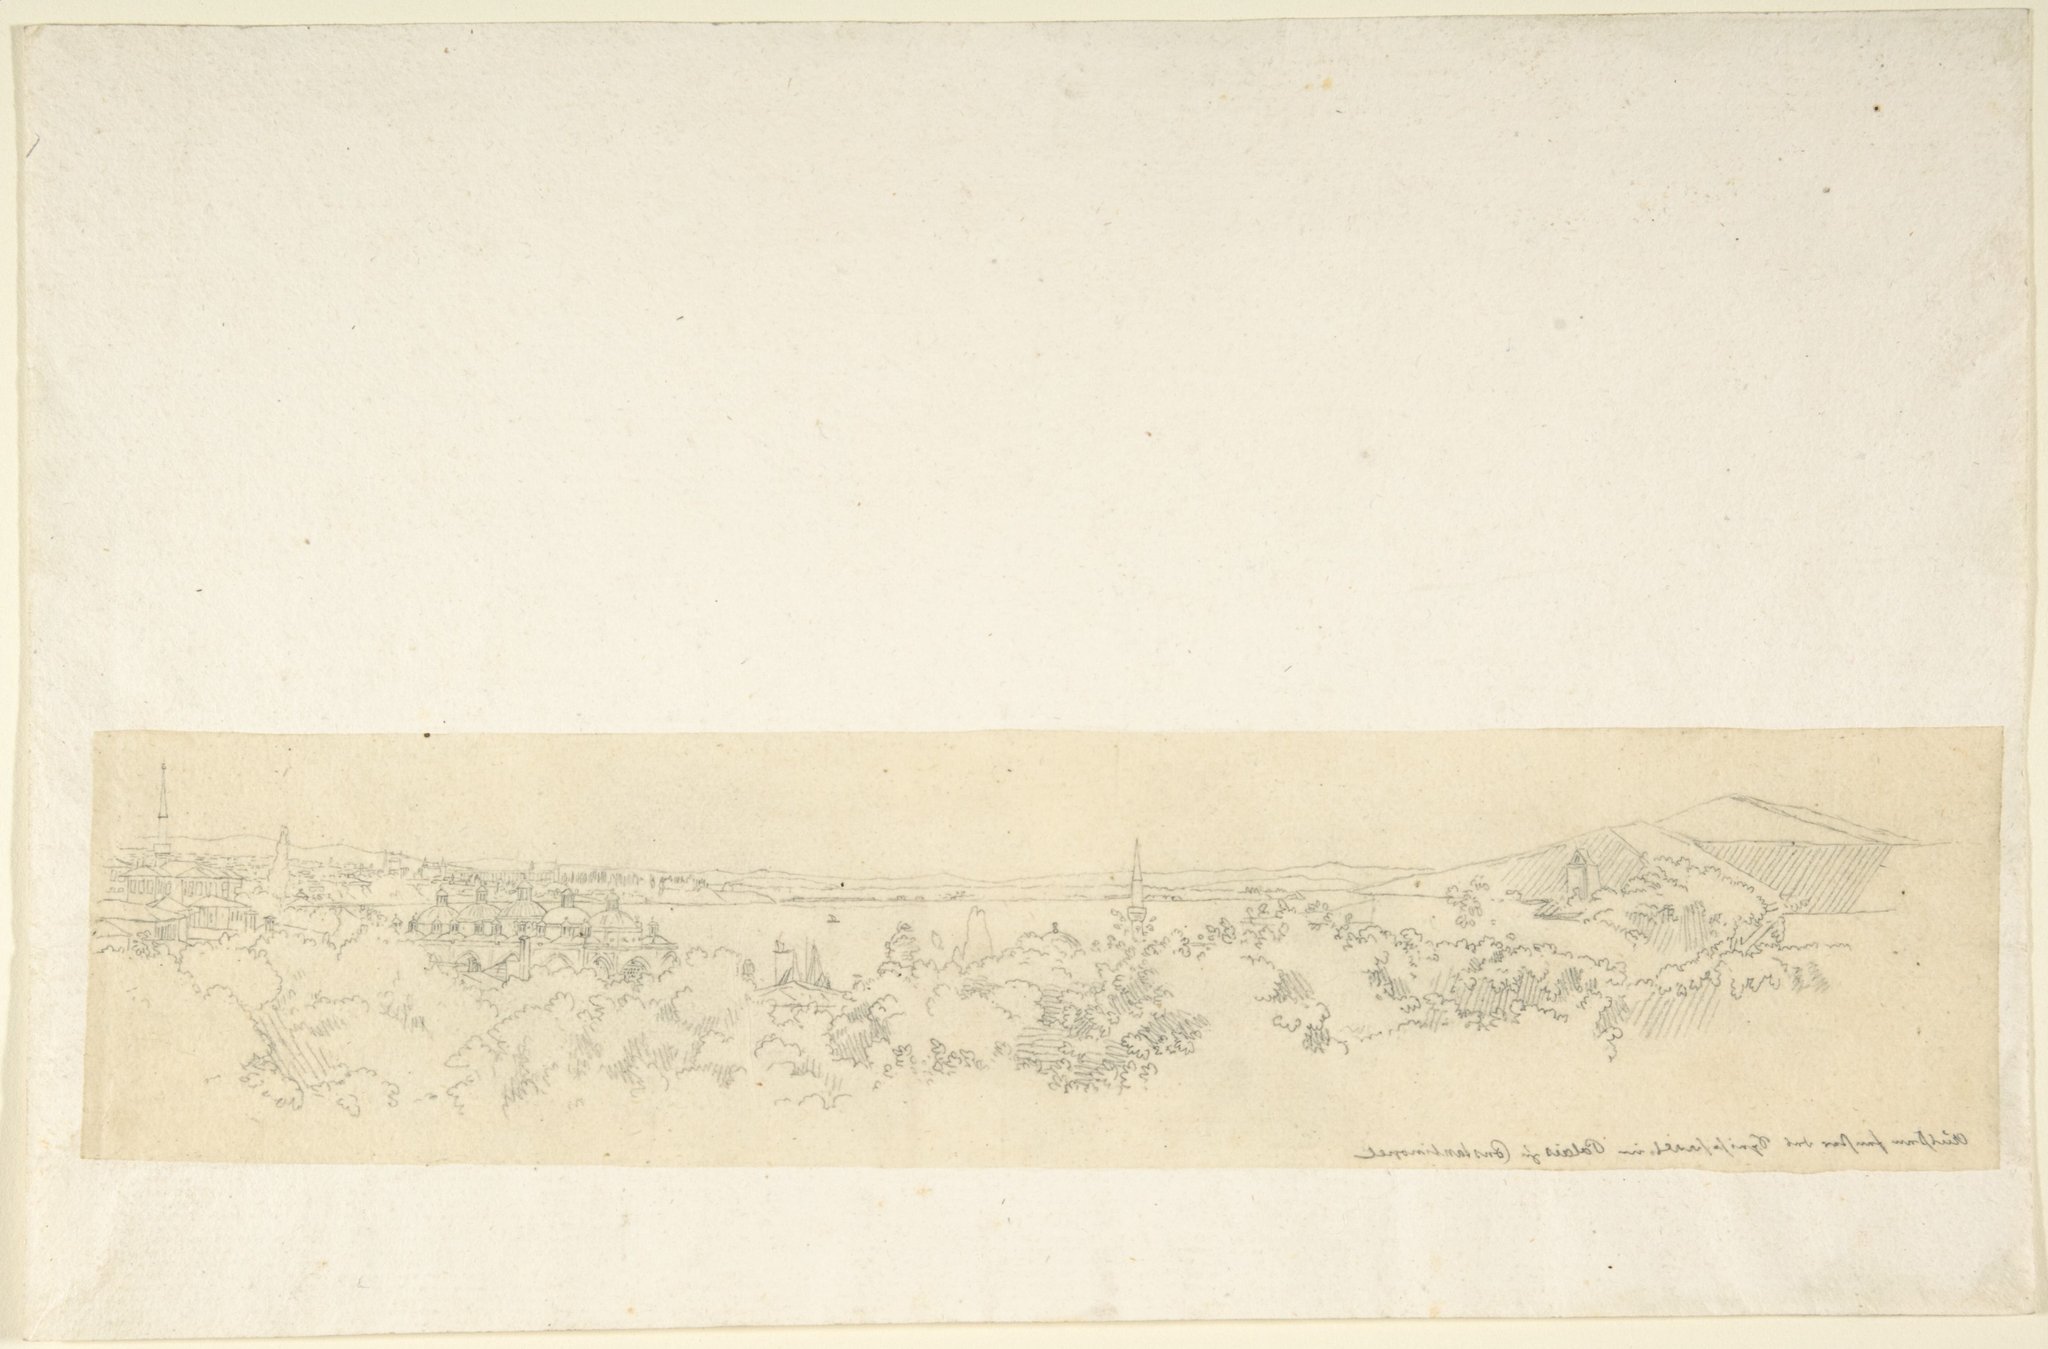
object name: drawing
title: Landscape near Constantinople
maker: franz von hauslab the younger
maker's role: artist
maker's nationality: austrian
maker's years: 1798-1883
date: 1801-1900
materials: paper, pencil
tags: buildings,landscapes